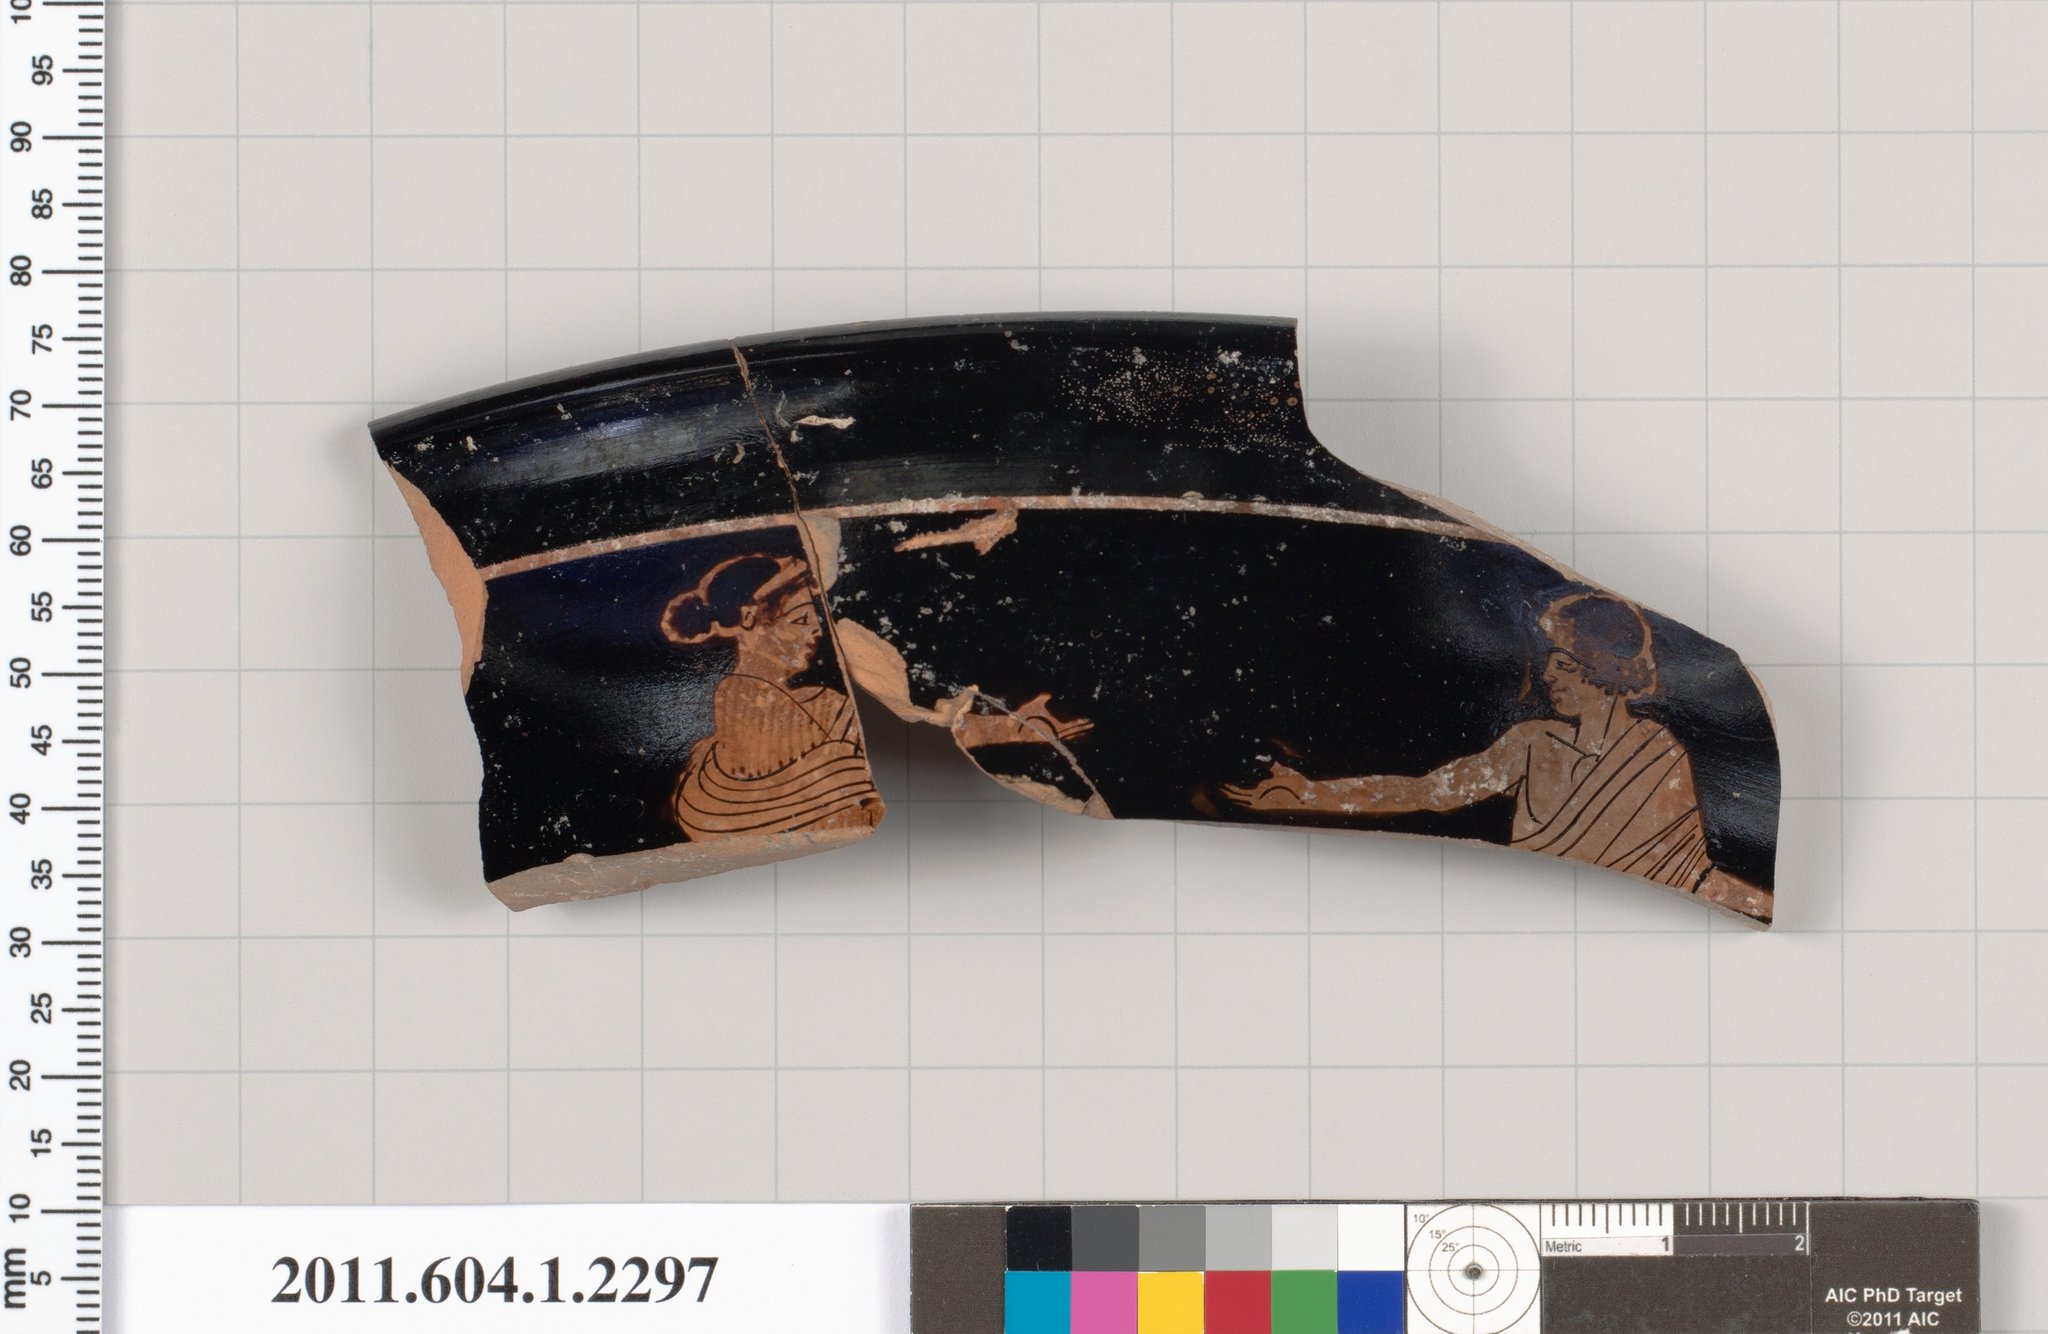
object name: kylix fragment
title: Terracotta fragment of a kylix (drinking cup)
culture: greek, attic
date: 460-450 BCE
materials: terracotta